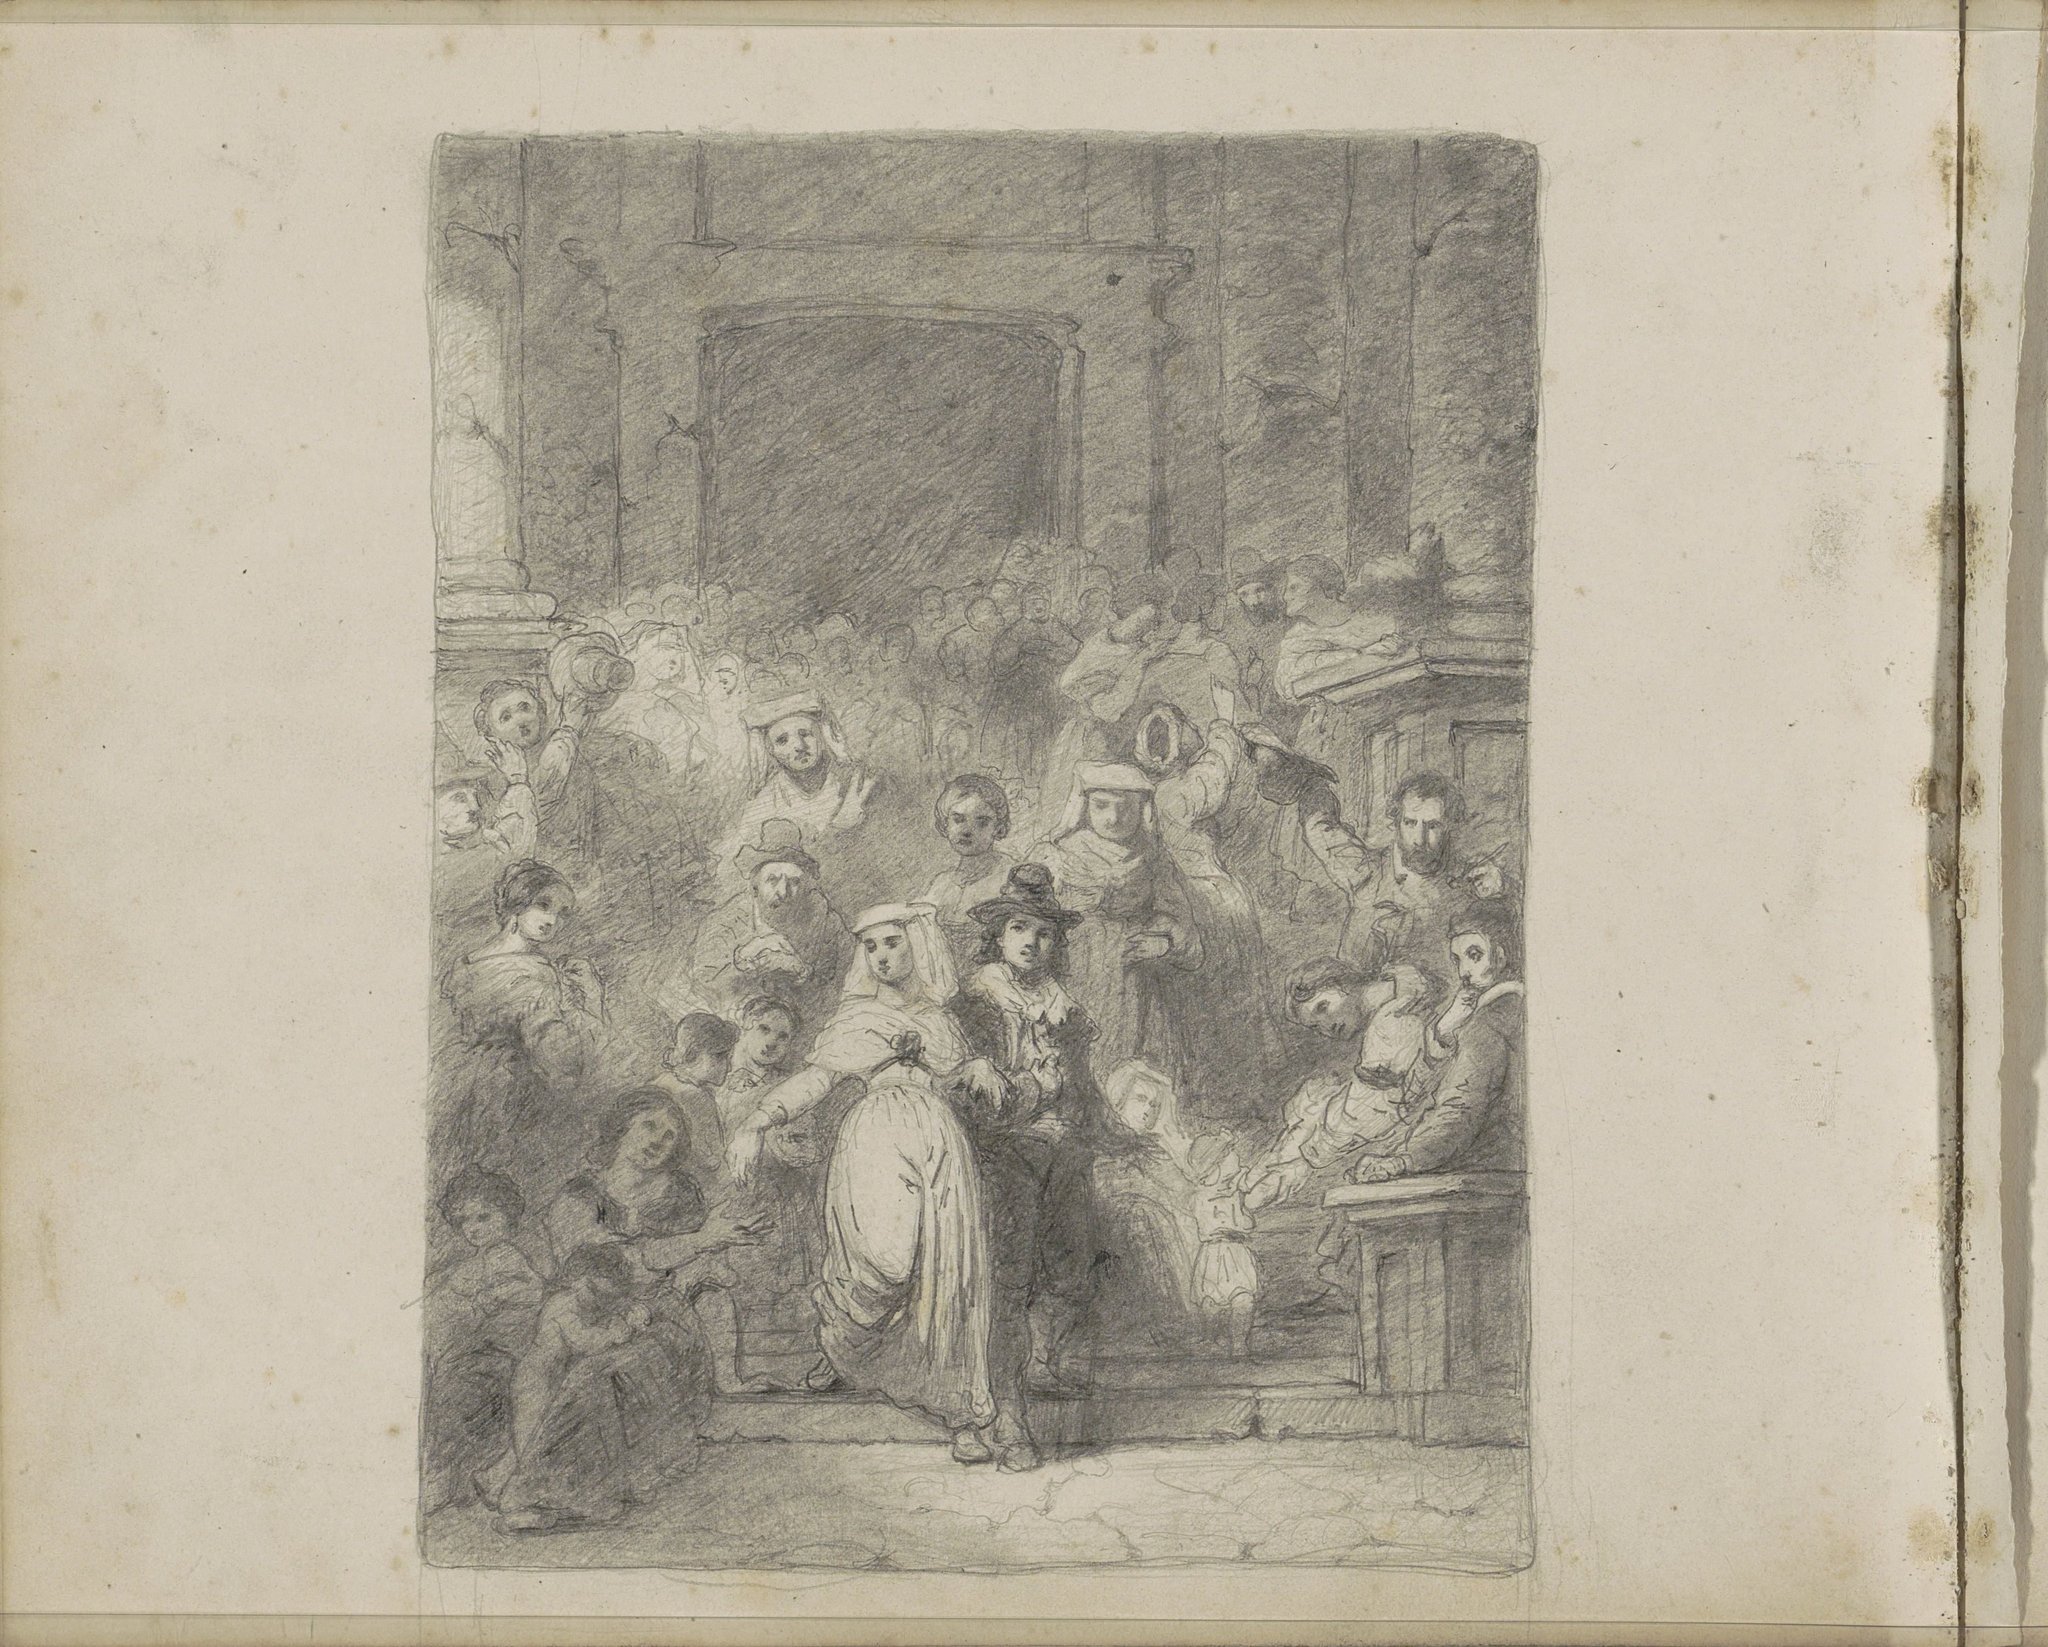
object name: sketchbook leaf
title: Getrouwd paar verlaat een kerk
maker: gerrit postma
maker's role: draughtsman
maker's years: 1819-1894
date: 1829-1894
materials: paper, pencil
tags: married couple leaving the church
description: Een paar in trouwkleding verlaat via een trap een kerk. Om hen heen staan mannen, vrouwen en kinderen. Tekening in een kader. Blad 22 verso uit een schetsboek met 35 bladen.